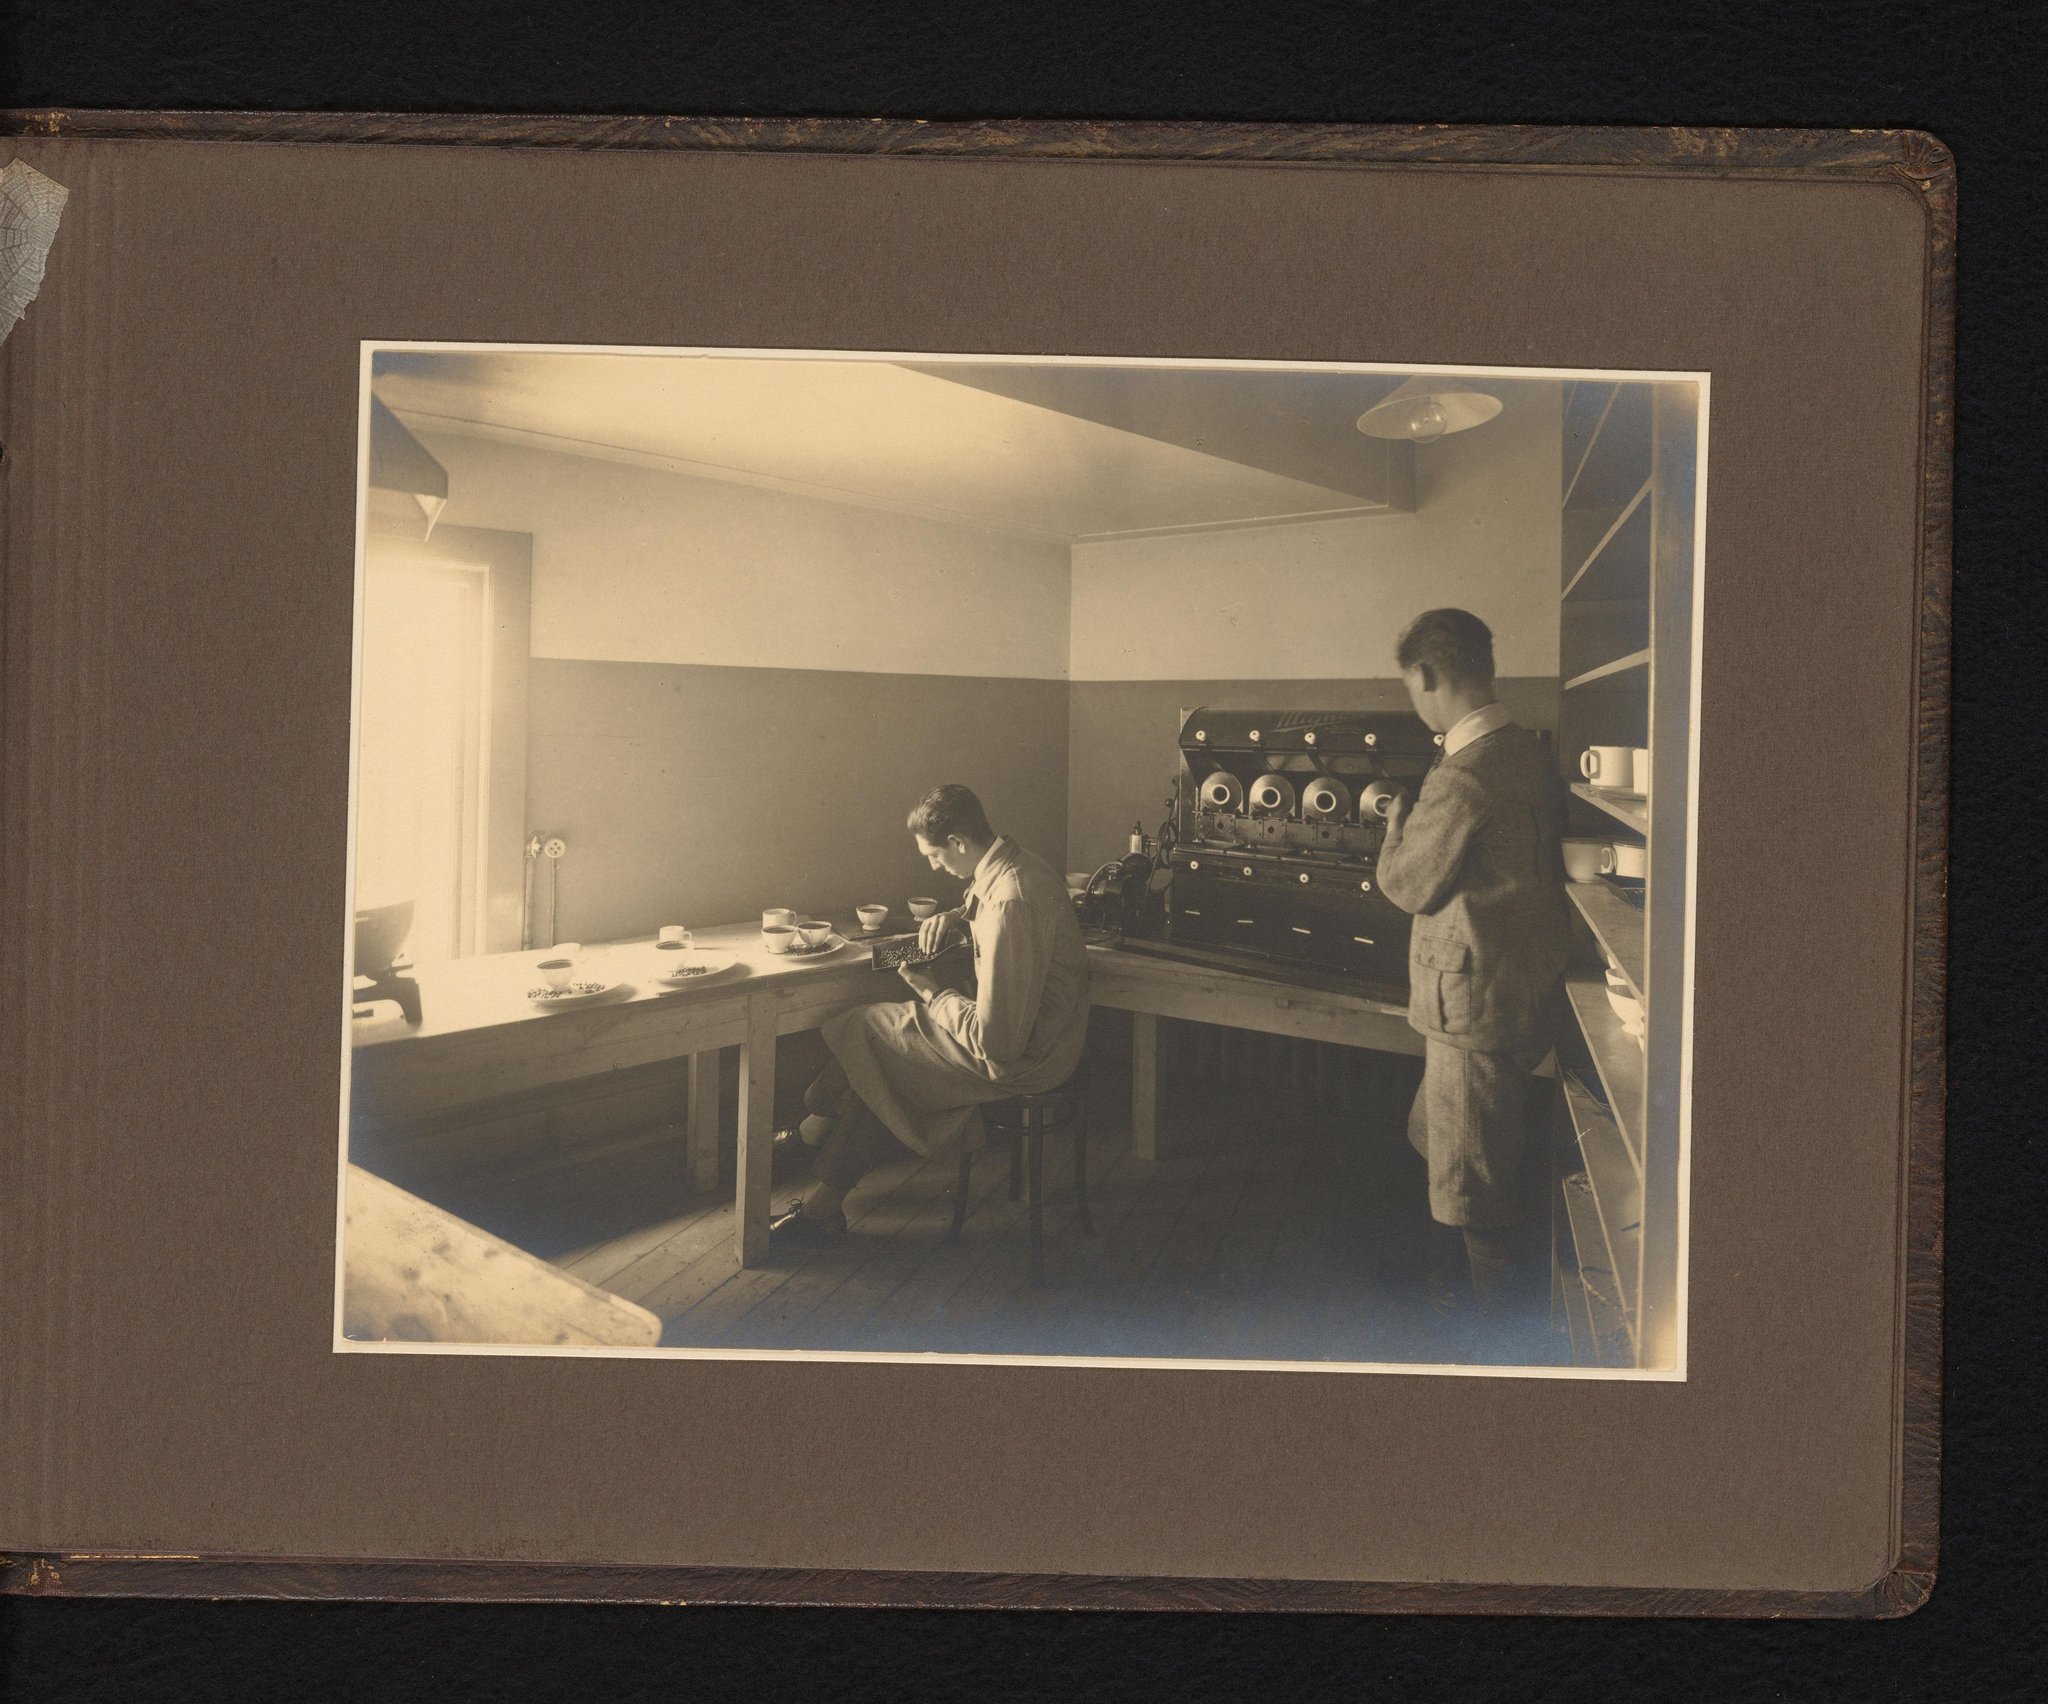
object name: photograph album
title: Fotoalbum met elf foto's van de firma Gebroeders Lomans in Amsterdam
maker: Anonymous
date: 1900-1930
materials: cardboard, cordage, paper, photographic support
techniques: gelatin silver print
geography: netherlands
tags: trade-company, coffee, tobacco, amsterdam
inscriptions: retailer's mark: ‘hK Co.’, collector's mark: ‘DIENST/ VERSPREIDE/ RIJKSKOLLEKTIES/ (...) A 1022’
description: Fotoalbum met elf foto's op elf bladen. Afgebeeld is het bedrijf Gebroeders Lomans aan de Kloveniersburgwal 57 in Amsterdam, waar koffie, tabak en mogelijk thee worden verpakt en verhandeld. Te zien zijn een vergaderzaal, een administratiekantoor en de uitvoering van kwaliteitscontroles, vermoedelijk in pakhuis N.V. Het Nederlandsche Veem.